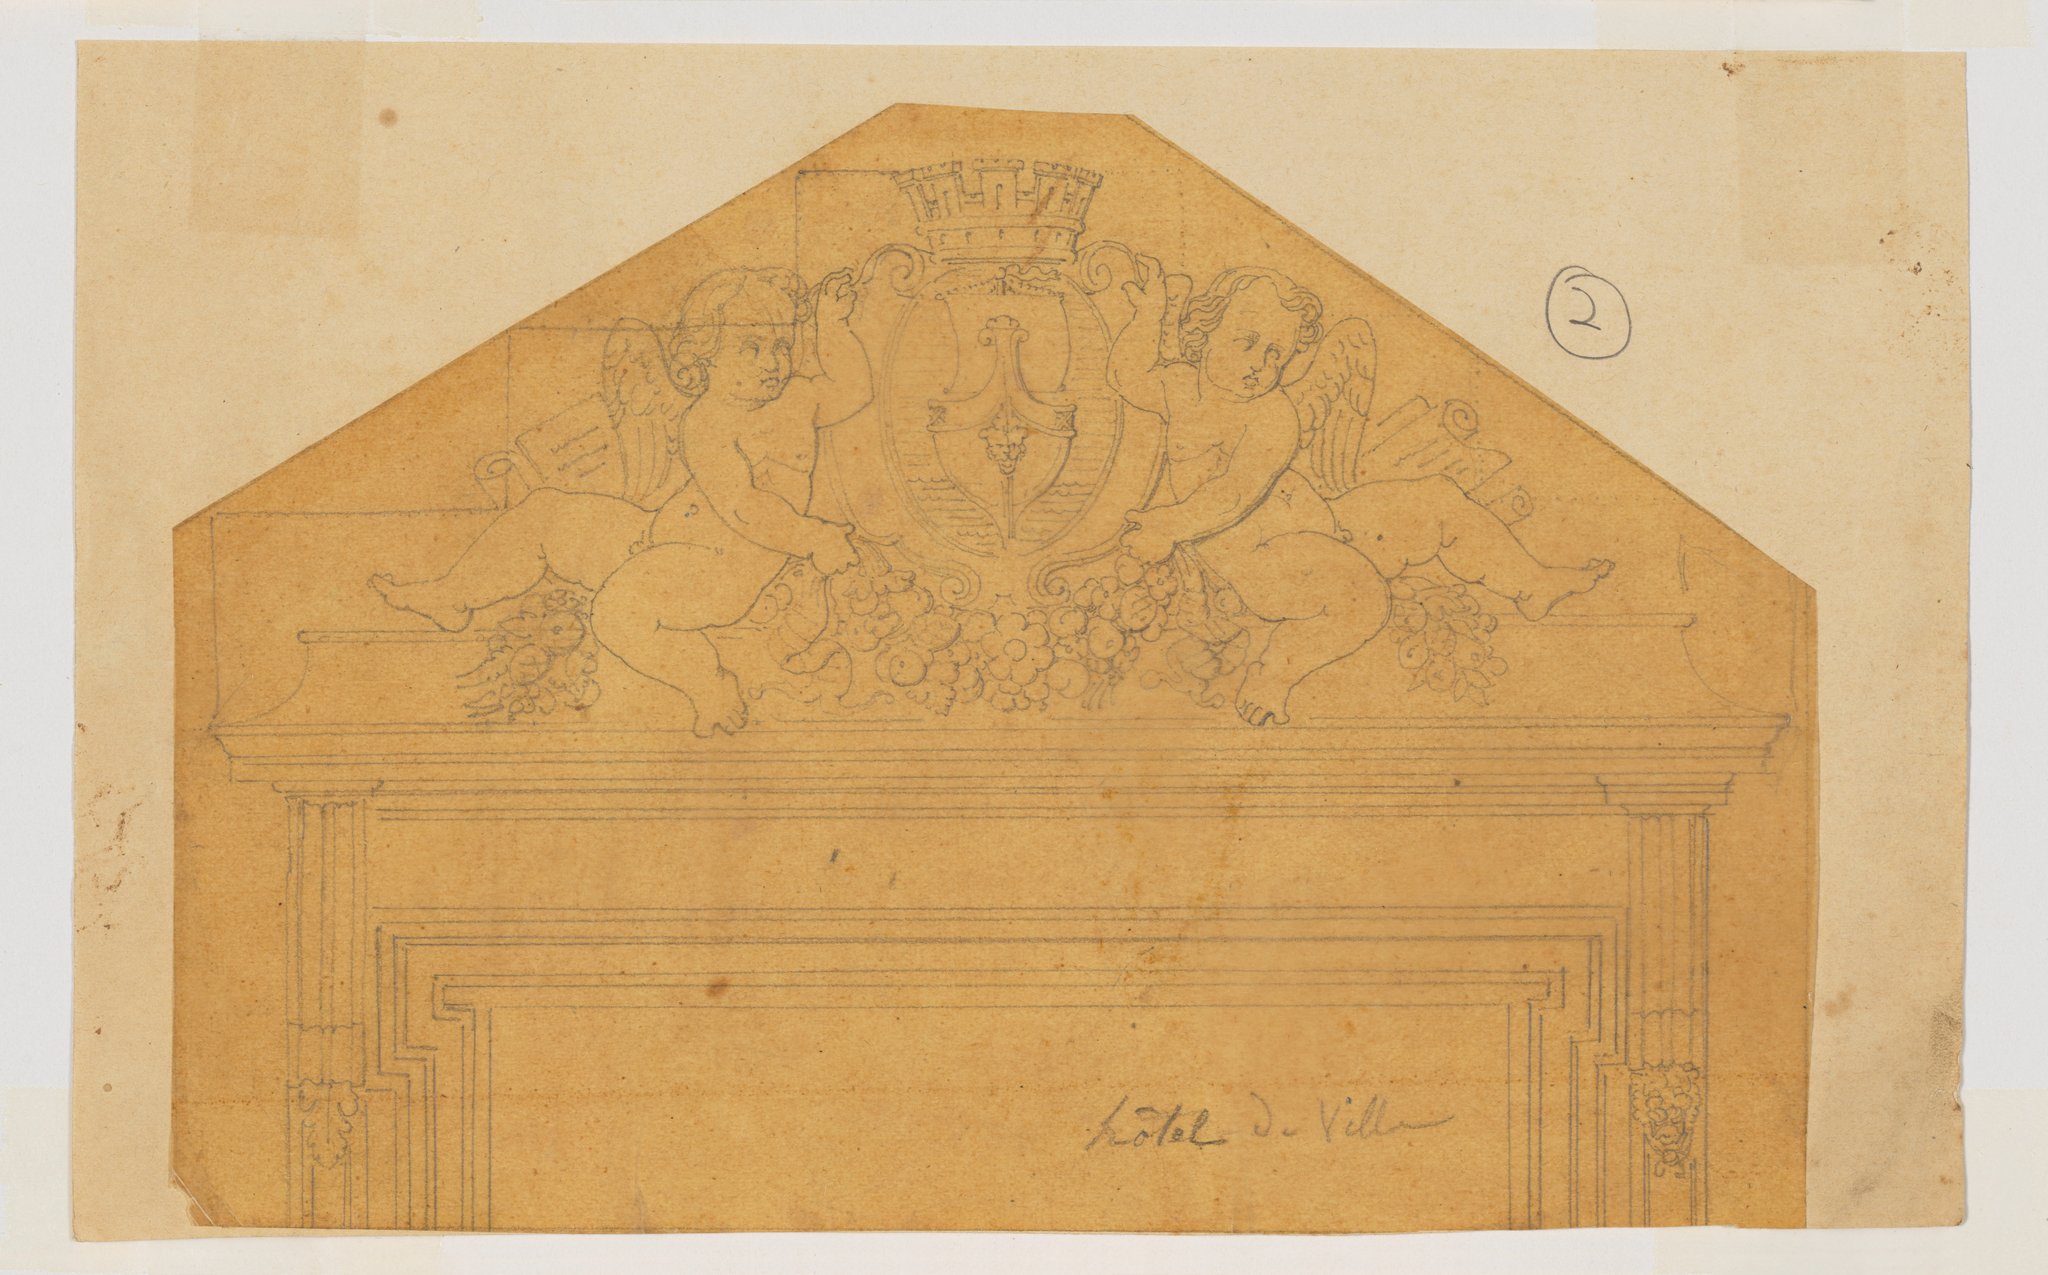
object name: drawing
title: Design for an Overdoor for the Hôtel de Ville with two outward facing Putting flanking a Coat of Arms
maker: jean-baptiste louis plantar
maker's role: artist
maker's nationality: french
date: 1834-1866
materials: graphite, ink, watercolor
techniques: pen